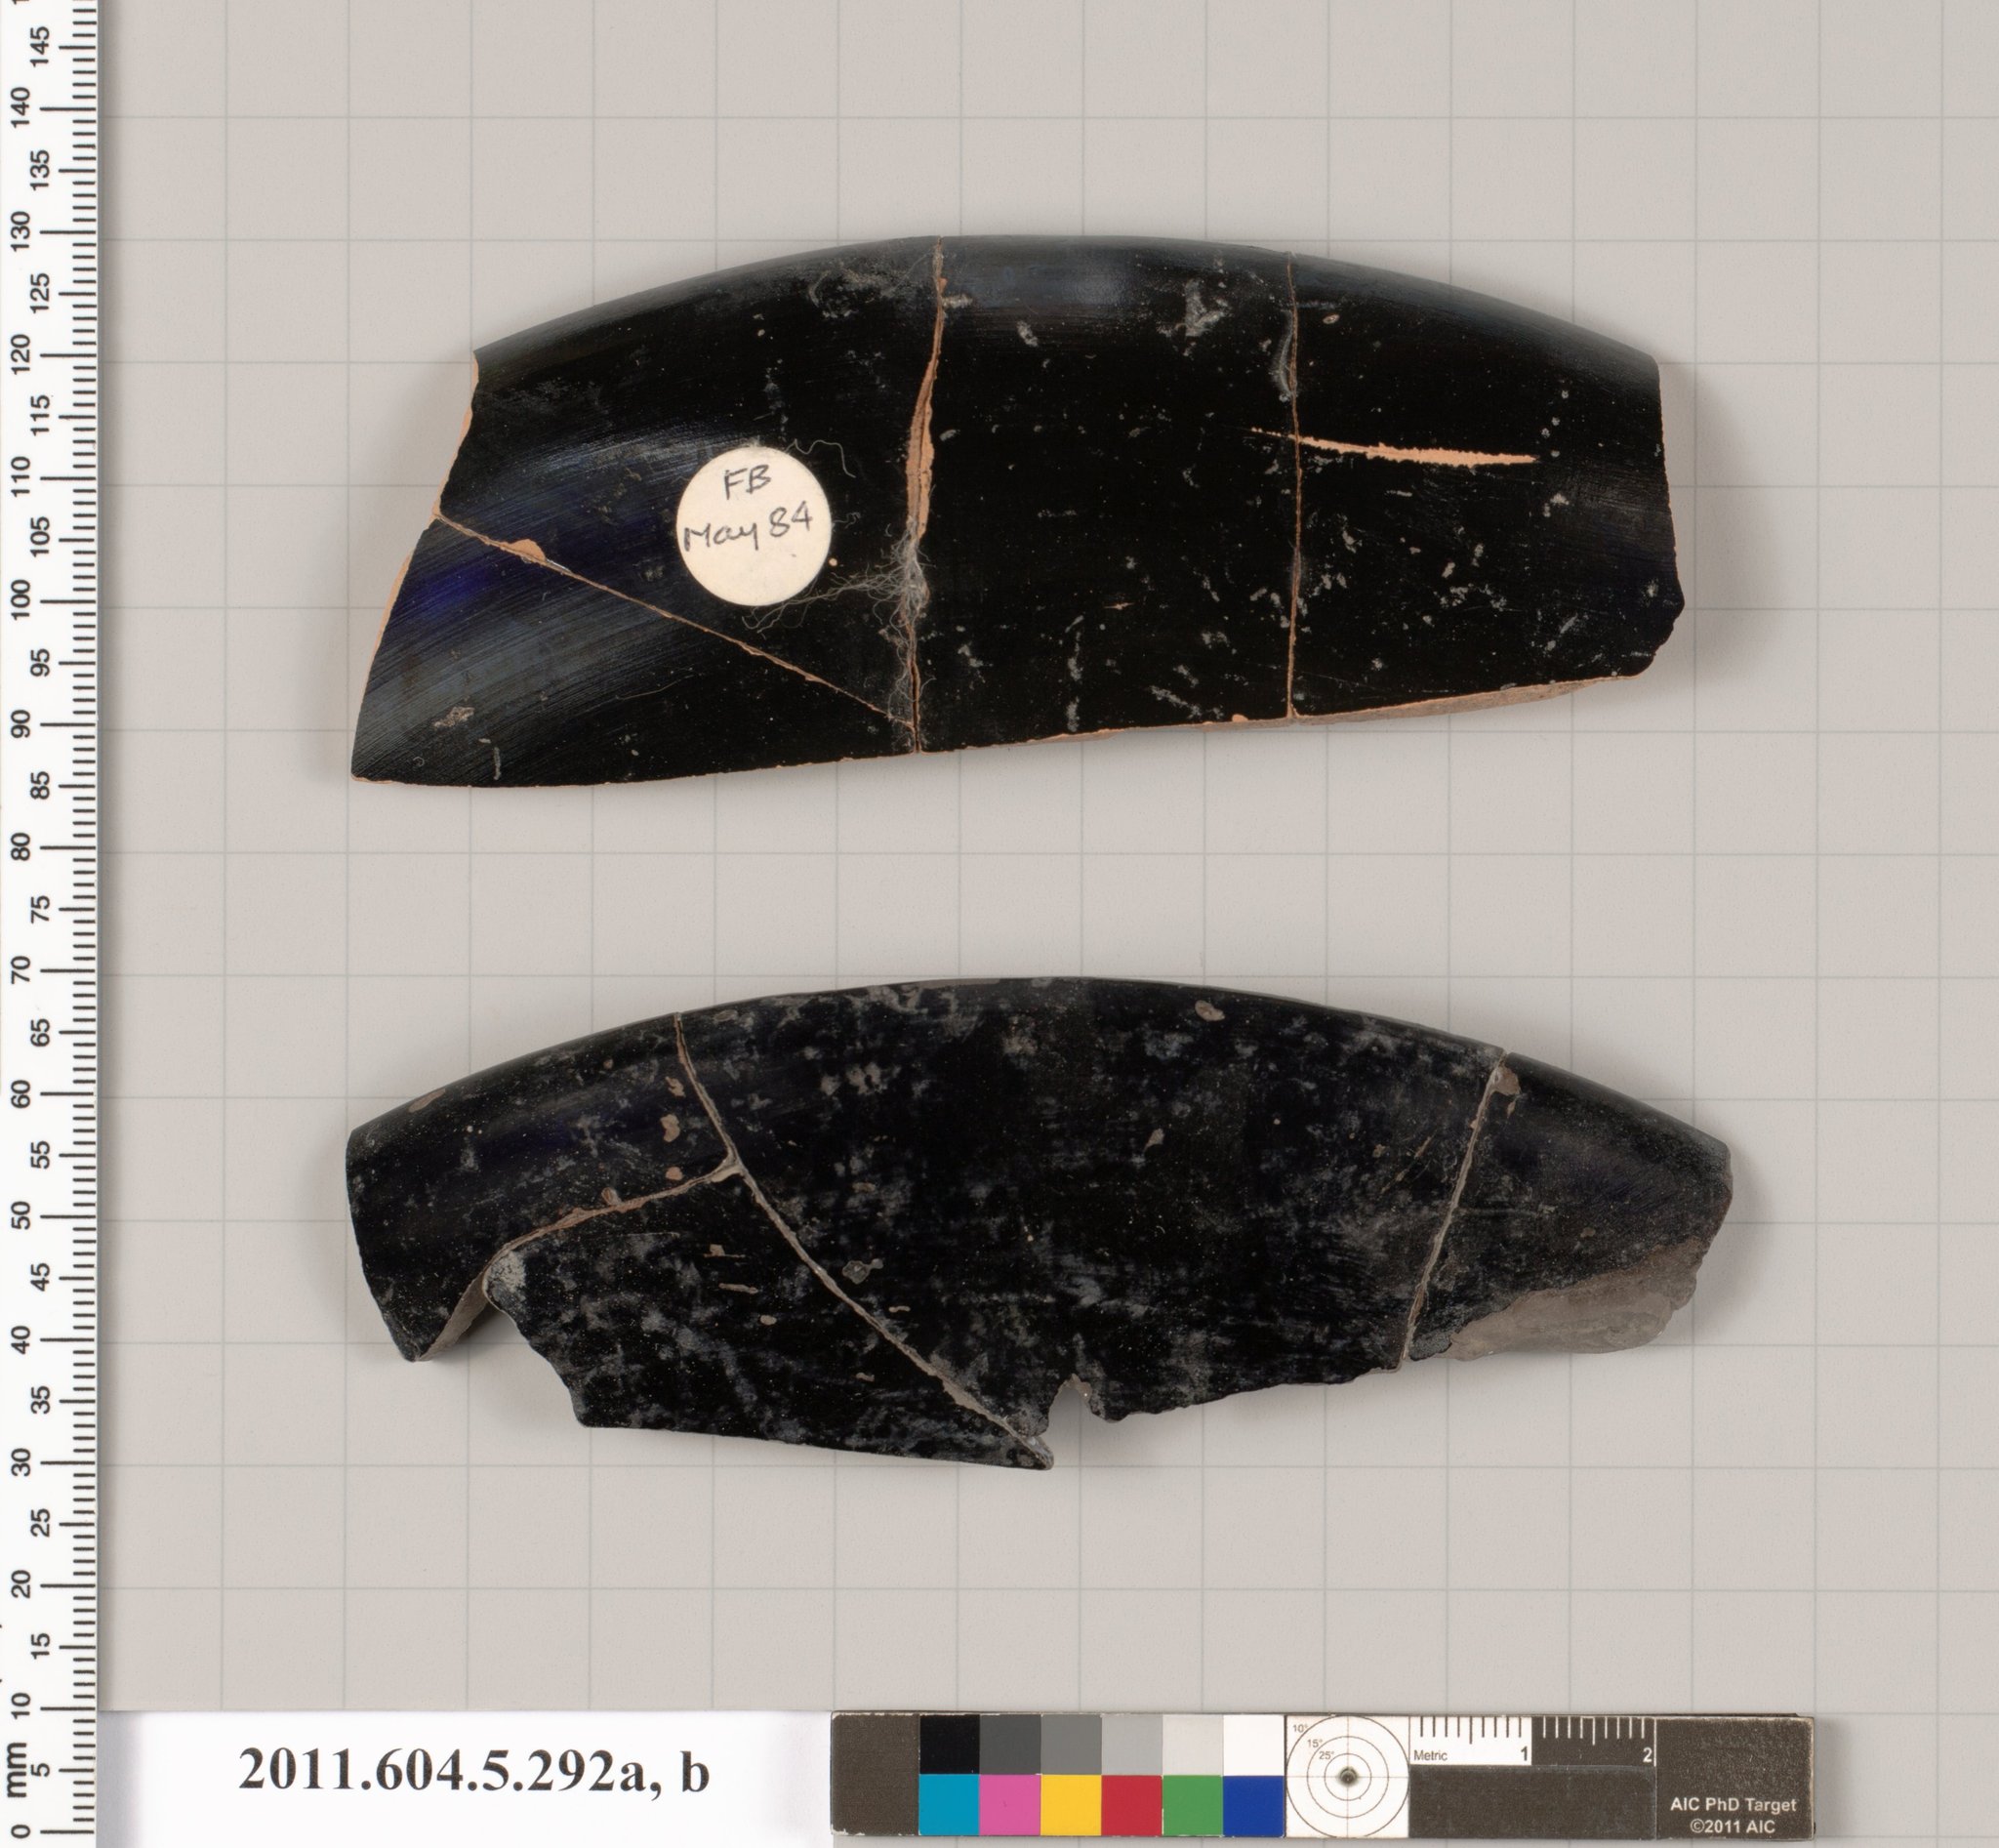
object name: kylix fragment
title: Terracotta rim fragments of kylikes (drinking cups)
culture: greek, attic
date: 600-401 BCE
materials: terracotta